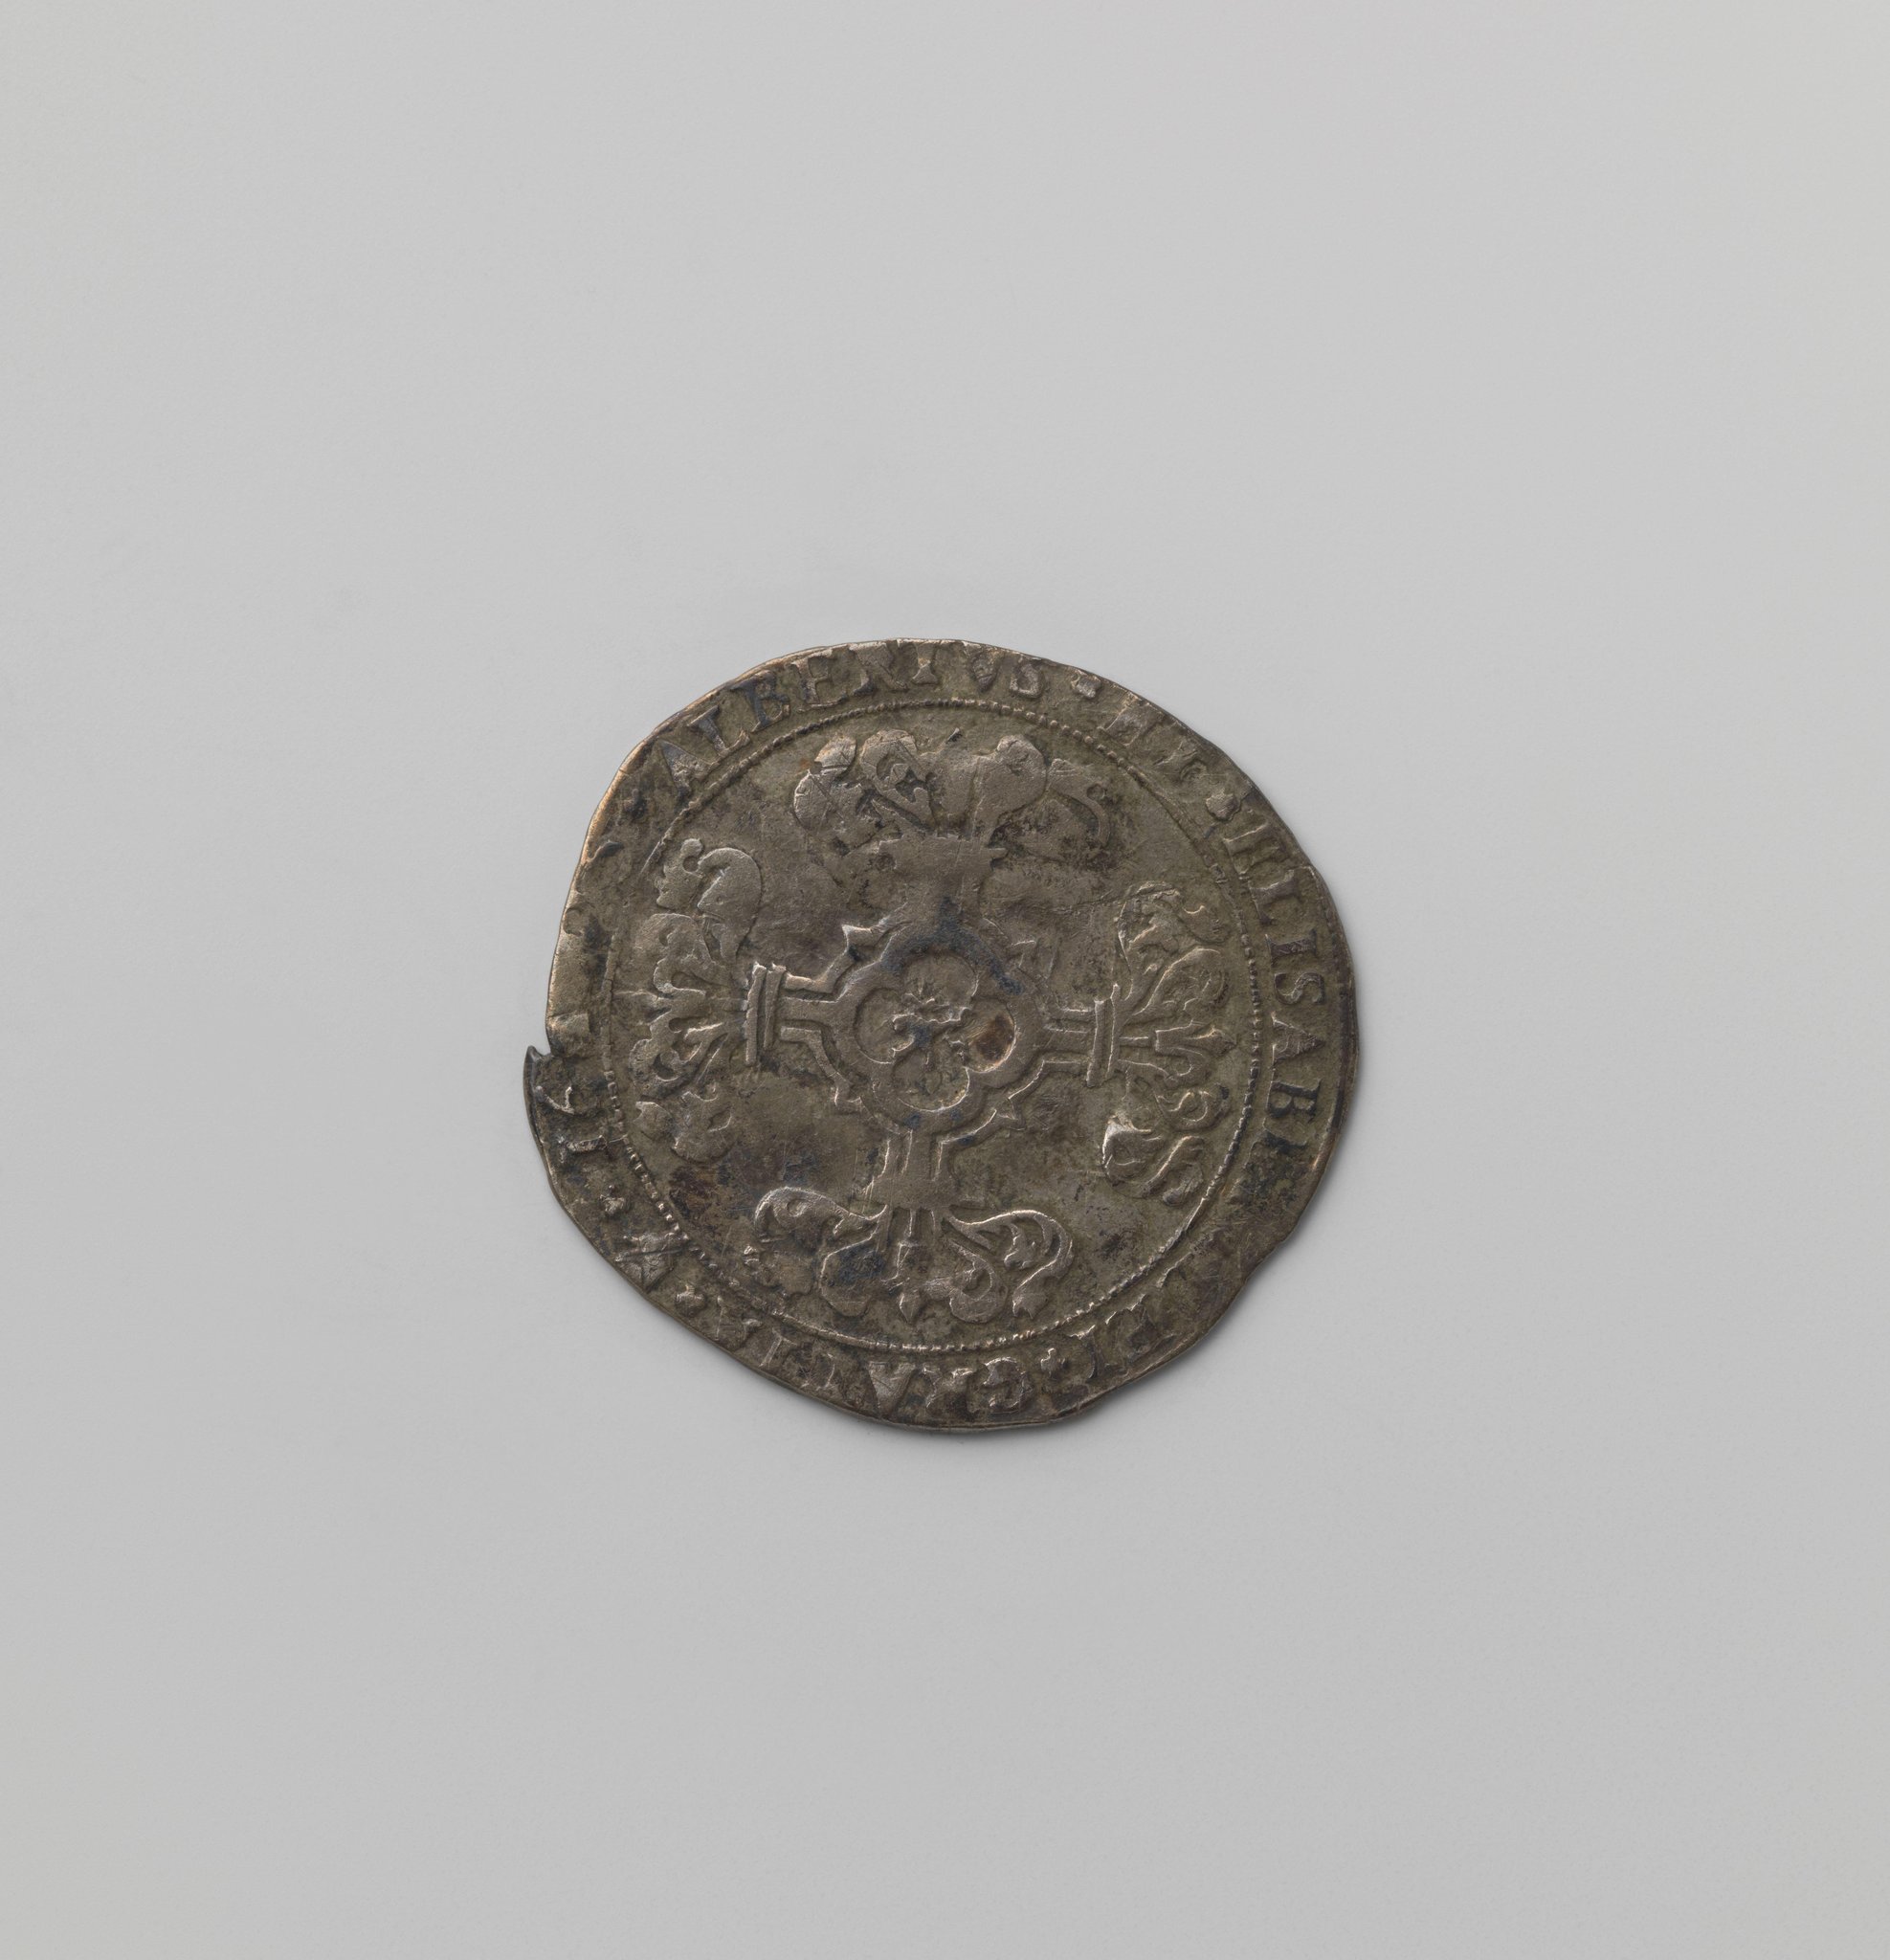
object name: coin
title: Brabant, Albert en Isabella, drie stuiver, 1615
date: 1615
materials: silver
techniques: striking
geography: antwerp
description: Zilveren munt. Voorzijde: in een veelpas gekroond samengesteld wapenschild. Keerzijde: kort gebloemd kruis, in het hart leeuw. Jaartal, waartussen kroon, bovenaan in omschrift. Daarvoor hand.